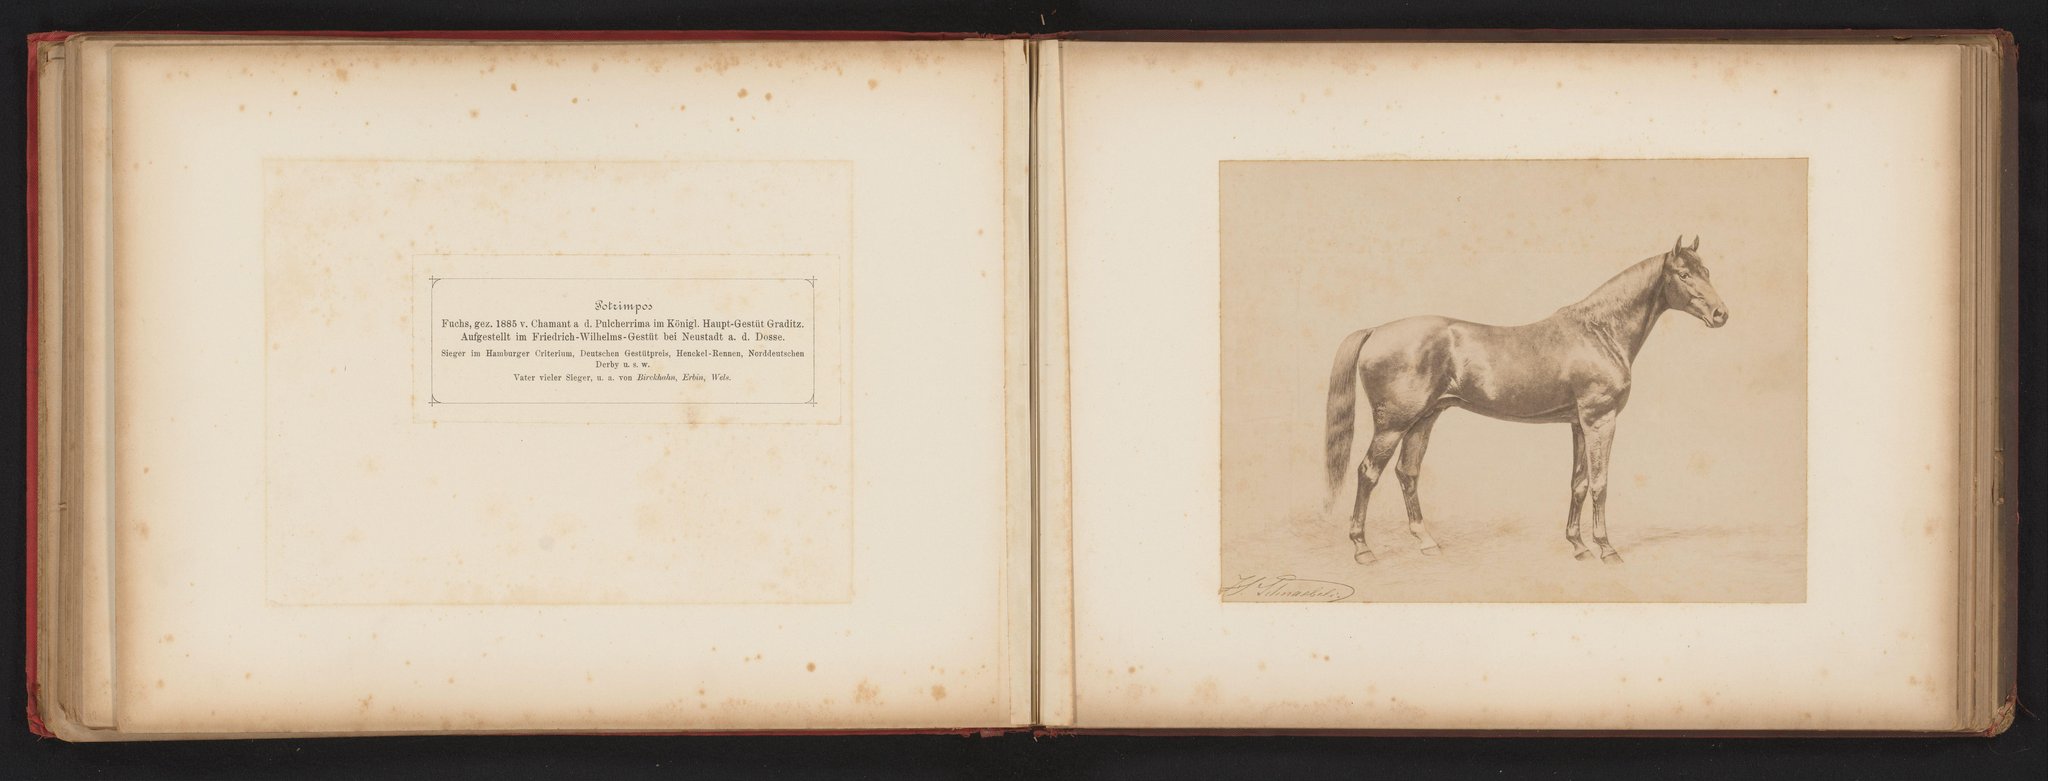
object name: page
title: Fotoreproductie van een tekening van een paard, genaamd Potrimpos, door H. Schnaebeli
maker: h. schnaebeli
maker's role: fotograaf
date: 1894-1915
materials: photographic support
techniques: albumen print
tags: horse